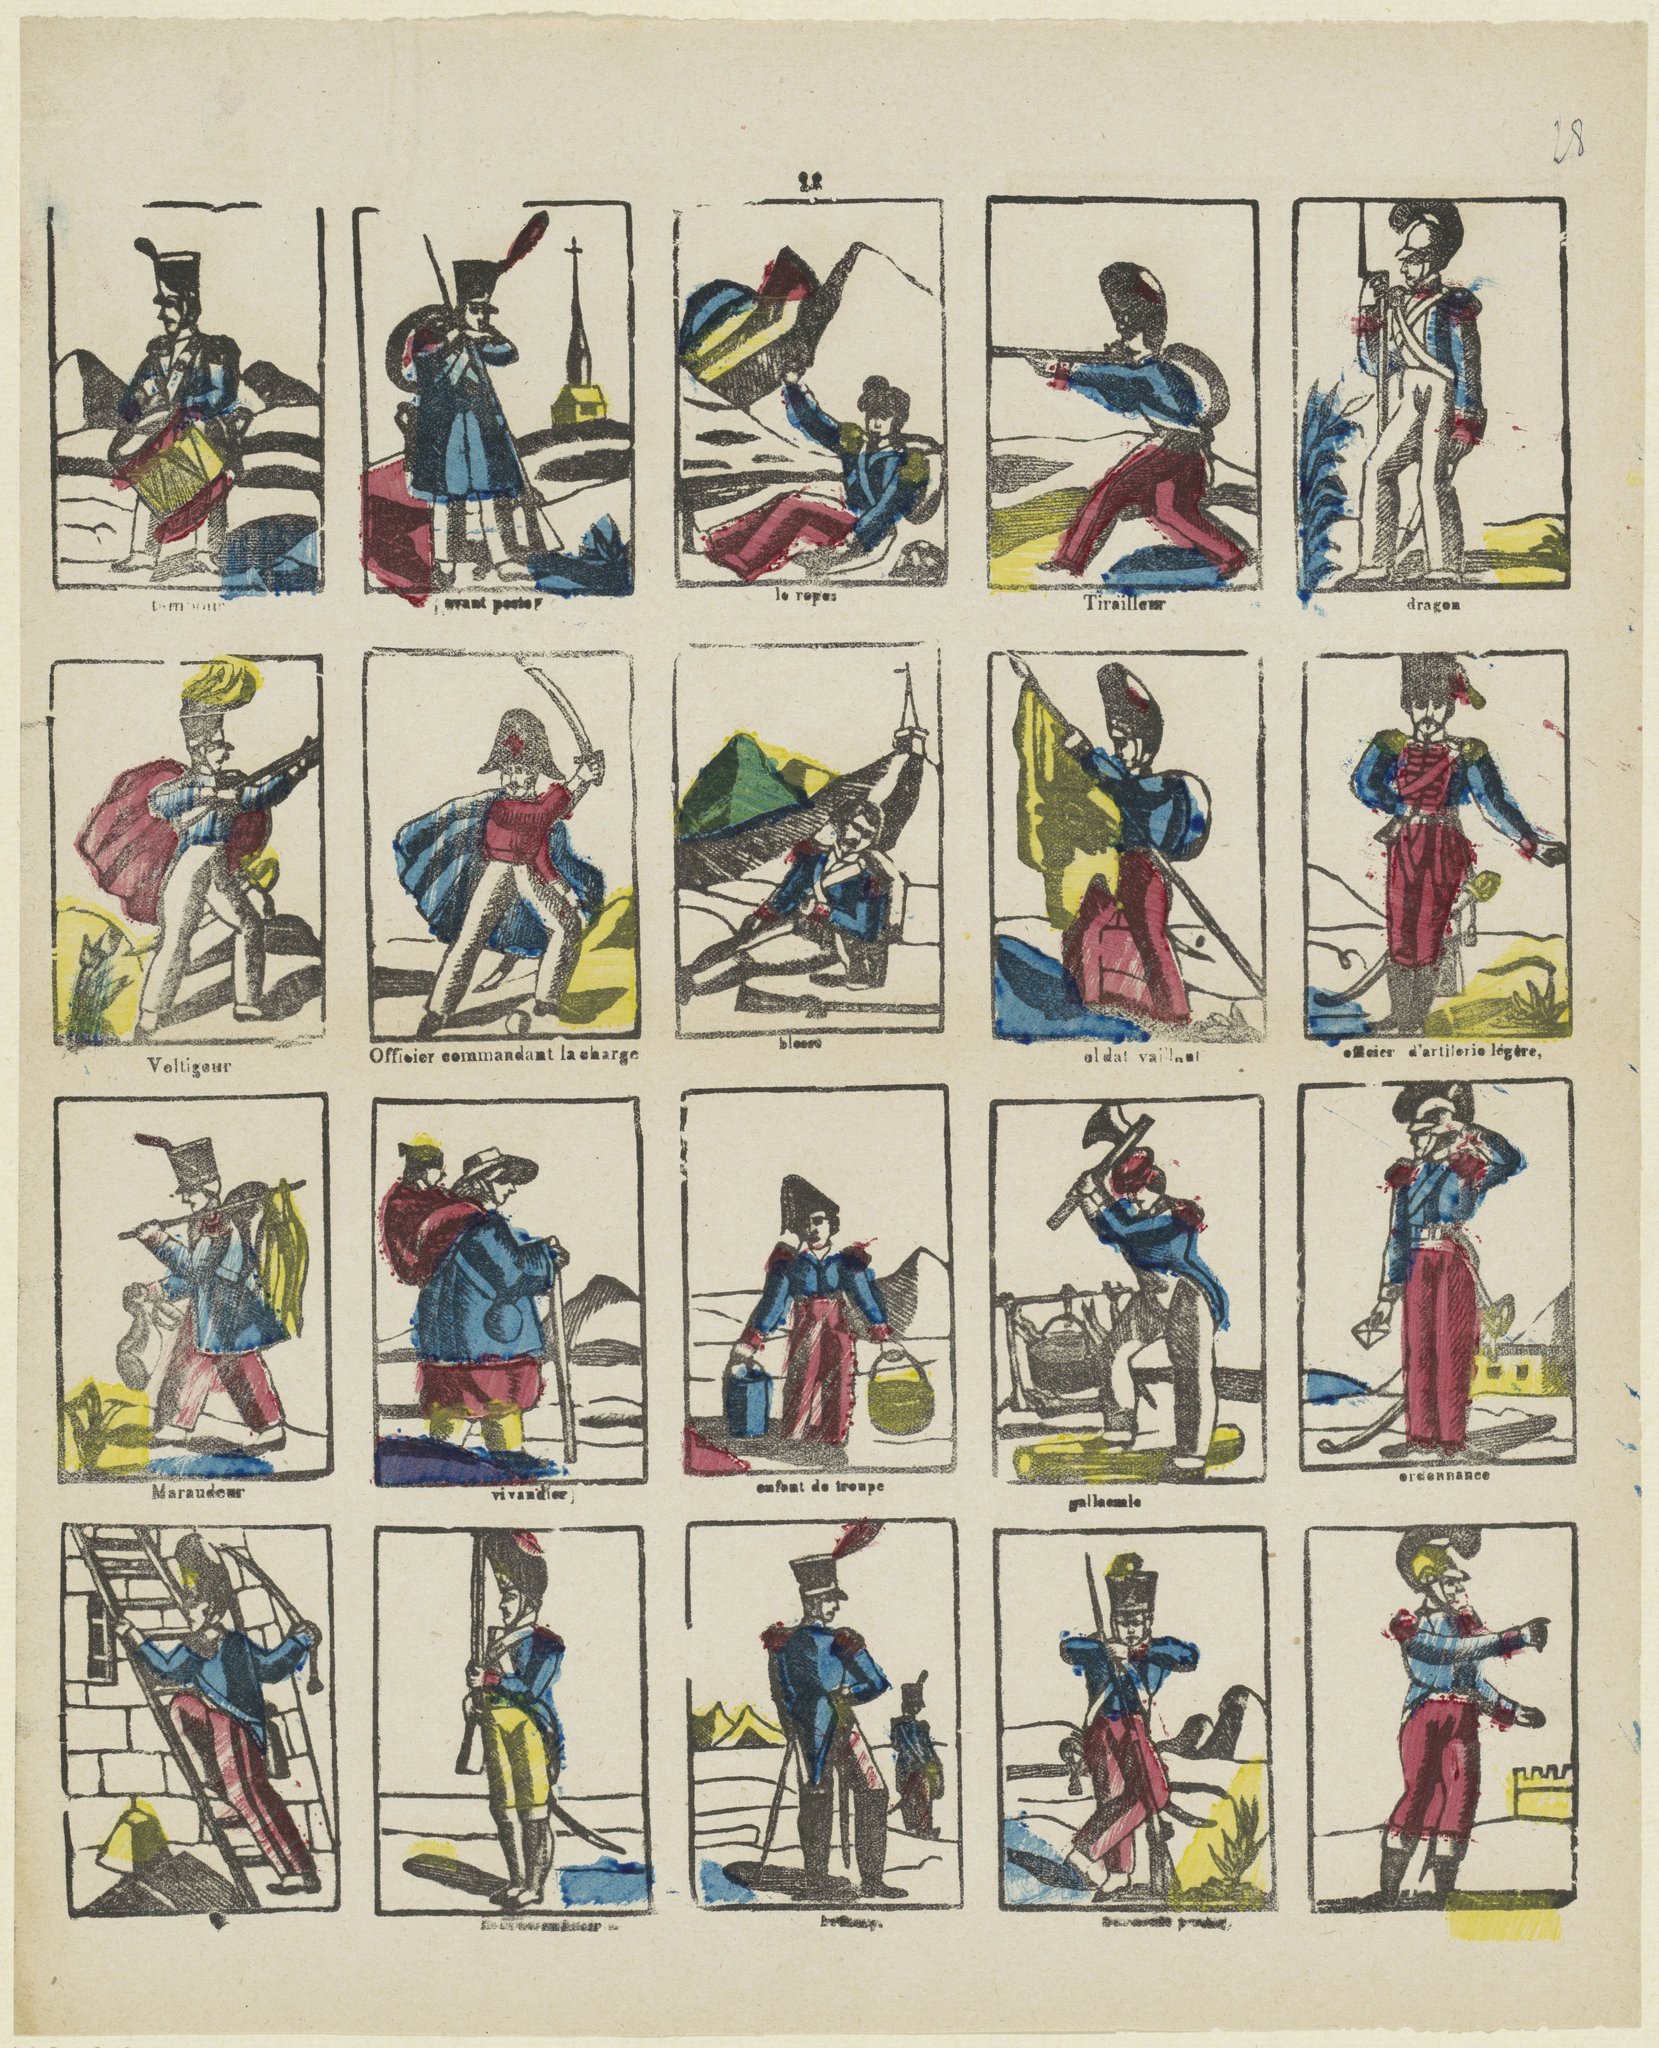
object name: print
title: Militairen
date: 1827-1894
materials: paper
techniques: colour, letterpress printing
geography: schaarbeek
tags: the soldier; the soldier's life, (military) uniforms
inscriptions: collector's mark: Lugt 2760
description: Blad met 20 voorstellingen van militairen. Onder enkele voorstellingen een onderschrift in het Frans. Genummerd midden boven: 28.